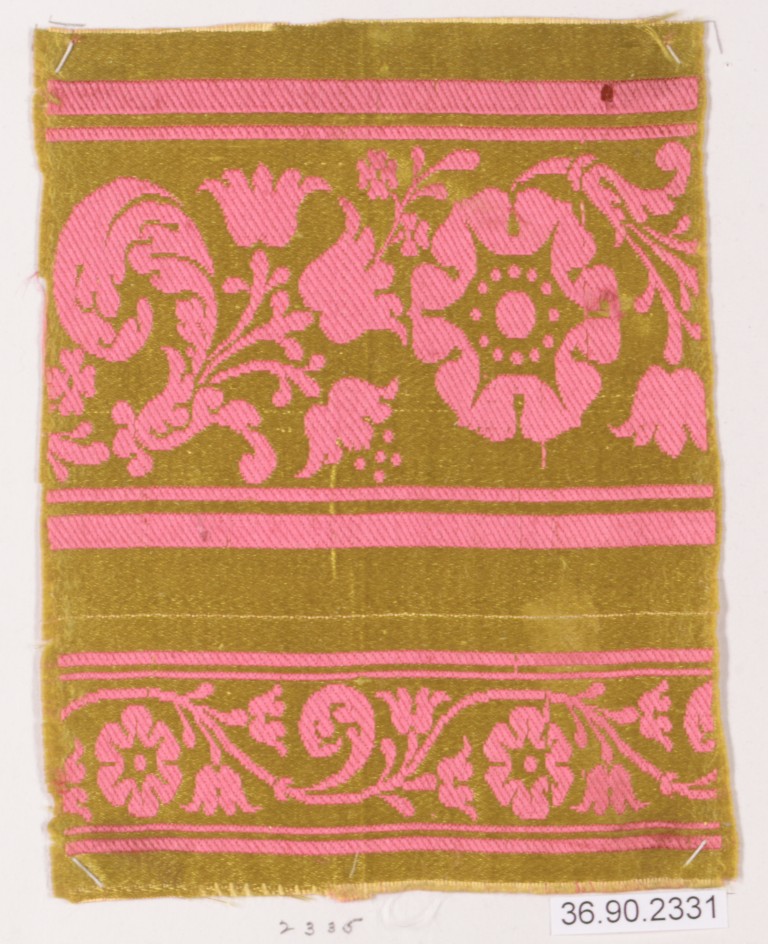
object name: piece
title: Pieces (9)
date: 1801-1900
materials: silk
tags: flowers